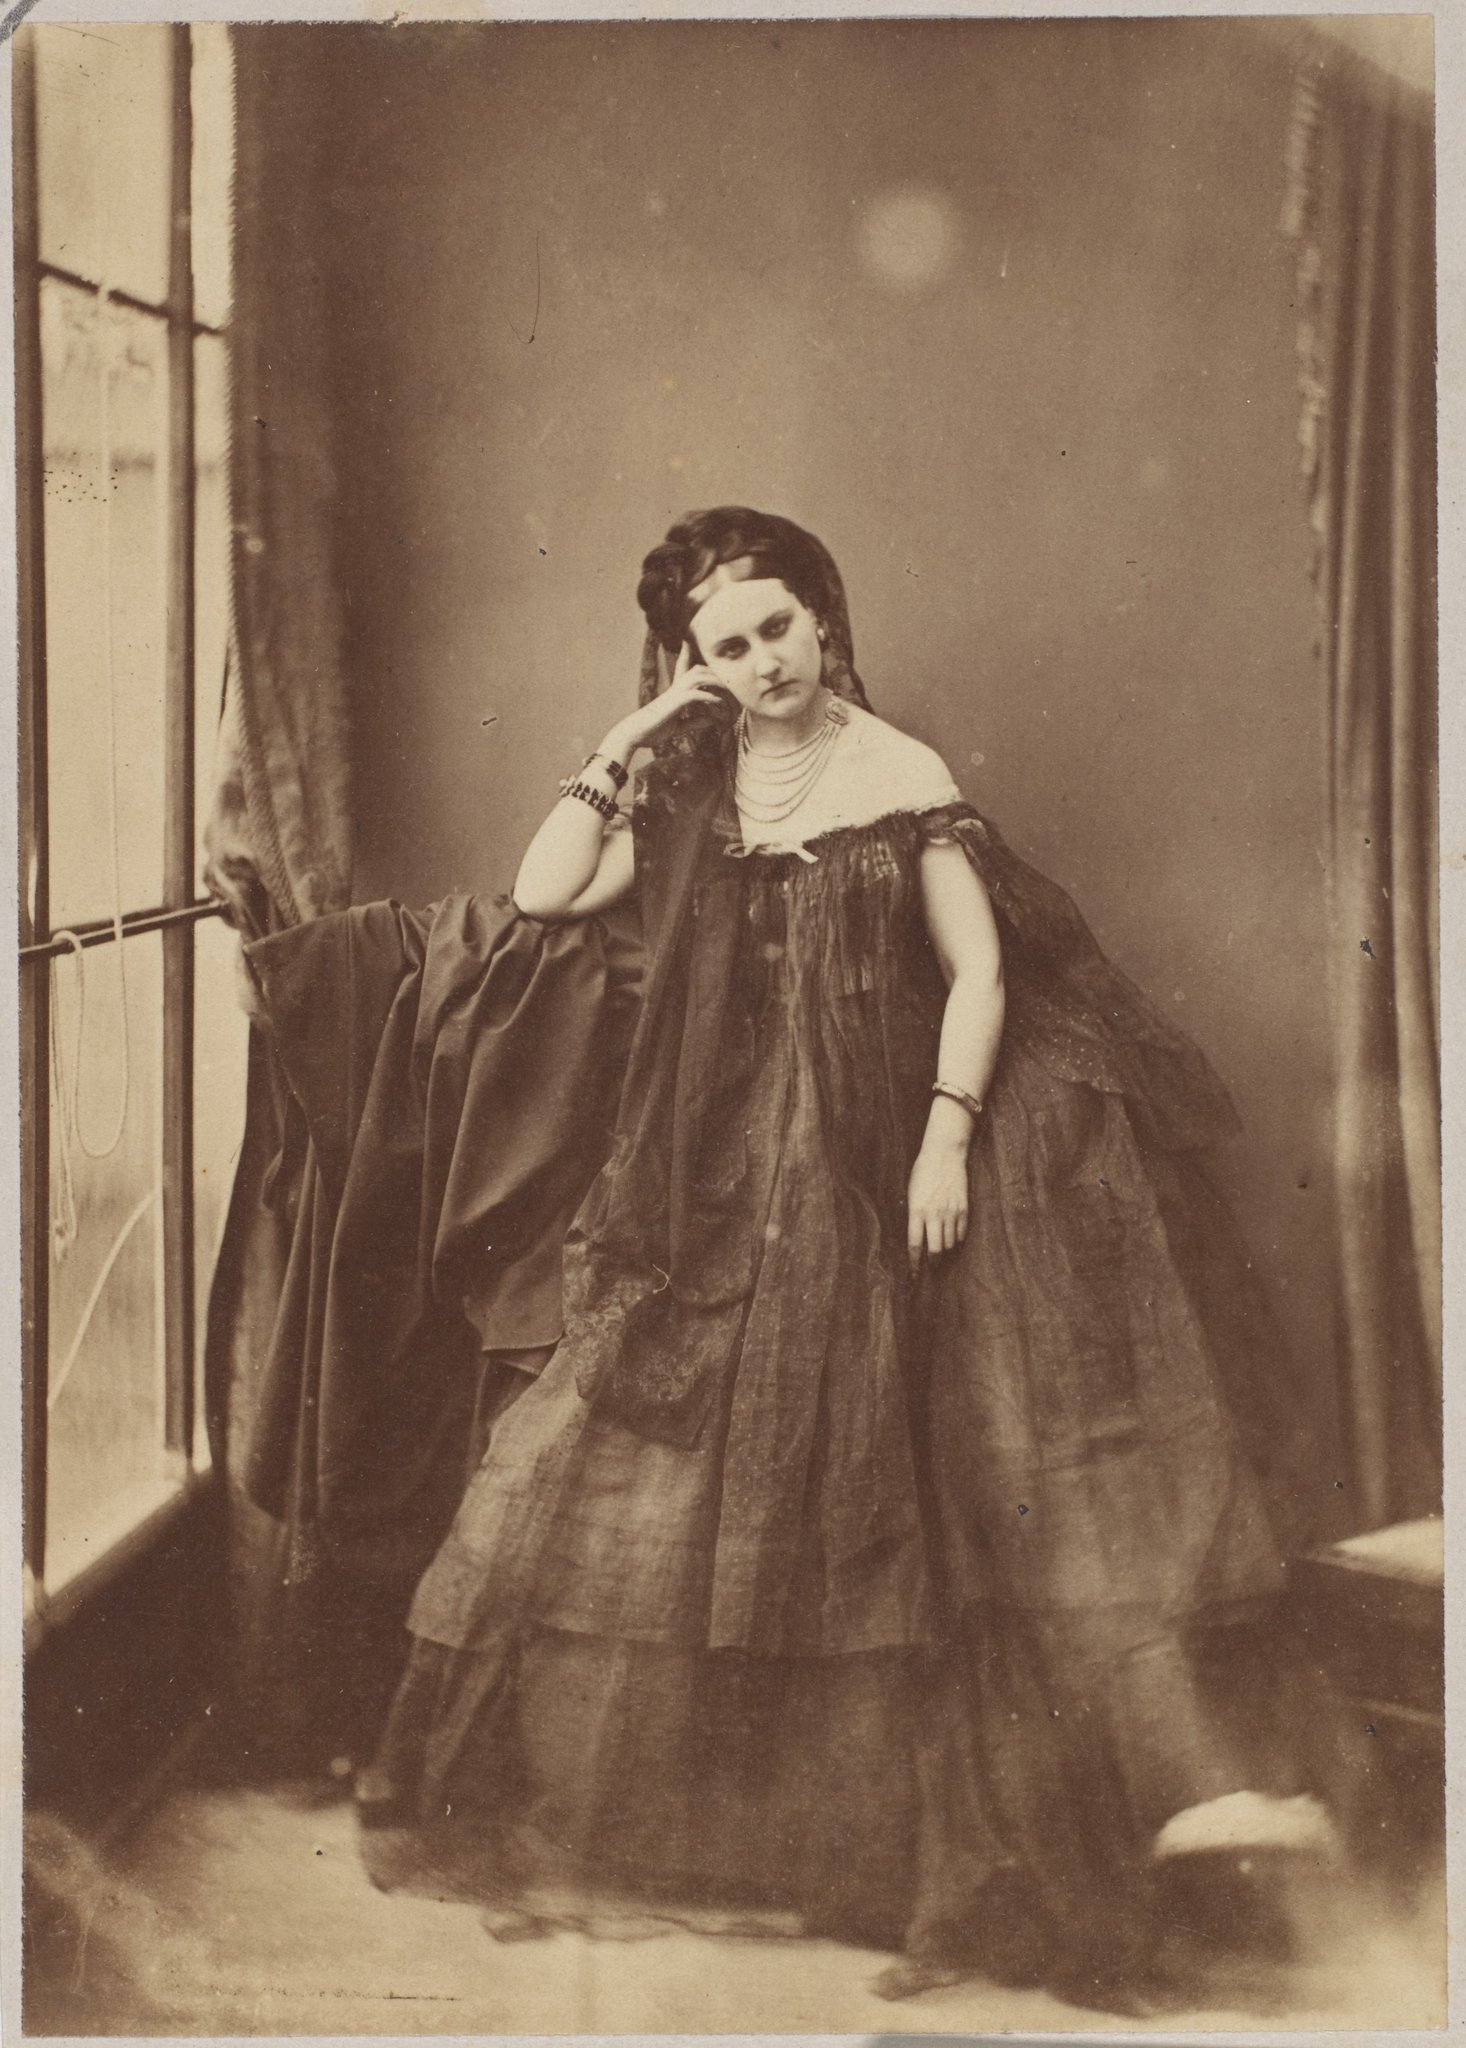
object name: photograph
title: L'accoudée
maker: pierre-louis pierson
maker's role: artist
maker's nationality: french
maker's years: 1822-1913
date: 1856-1857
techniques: albumen silver print, glass negative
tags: portraits,women